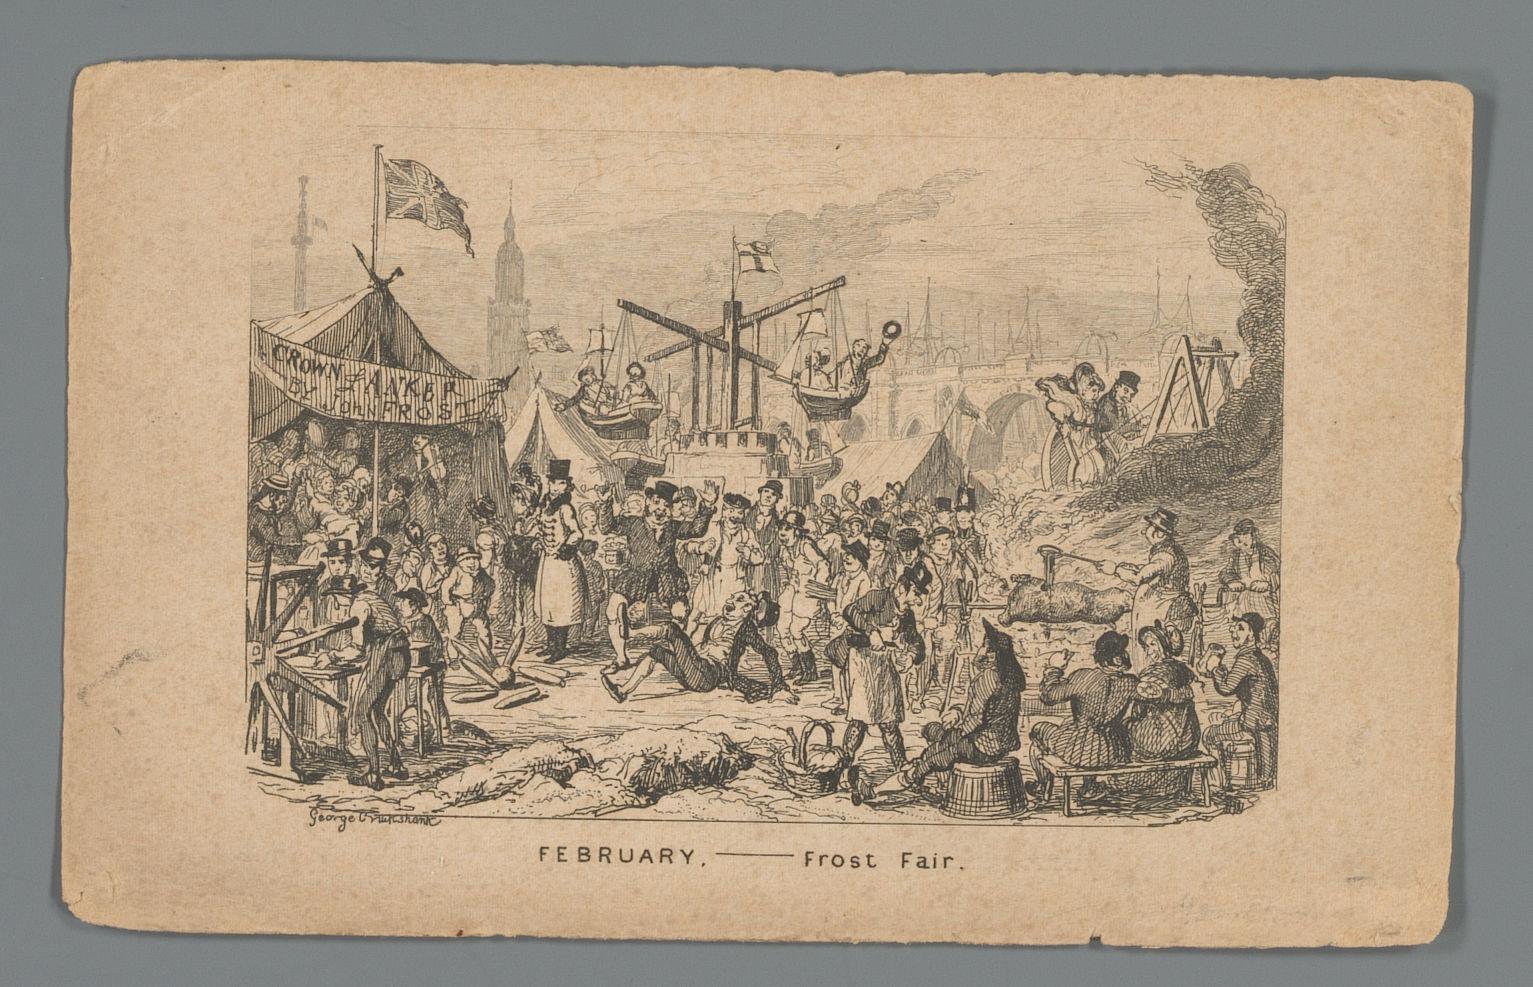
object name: cartoon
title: Februari: kermis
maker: george cruikshank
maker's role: painter, print maker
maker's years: 1792-1878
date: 1838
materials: paper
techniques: etching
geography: england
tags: february; 'febraro' (ripa), pleasure fair and circus, political caricatures and satires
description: Kermis op het ijs van de bevroren Theems. Stalletjes met eten en drinken en kermisattracties. Illustratie voor de maand februari uit een uitgave van: The Comic Almanack (1838).